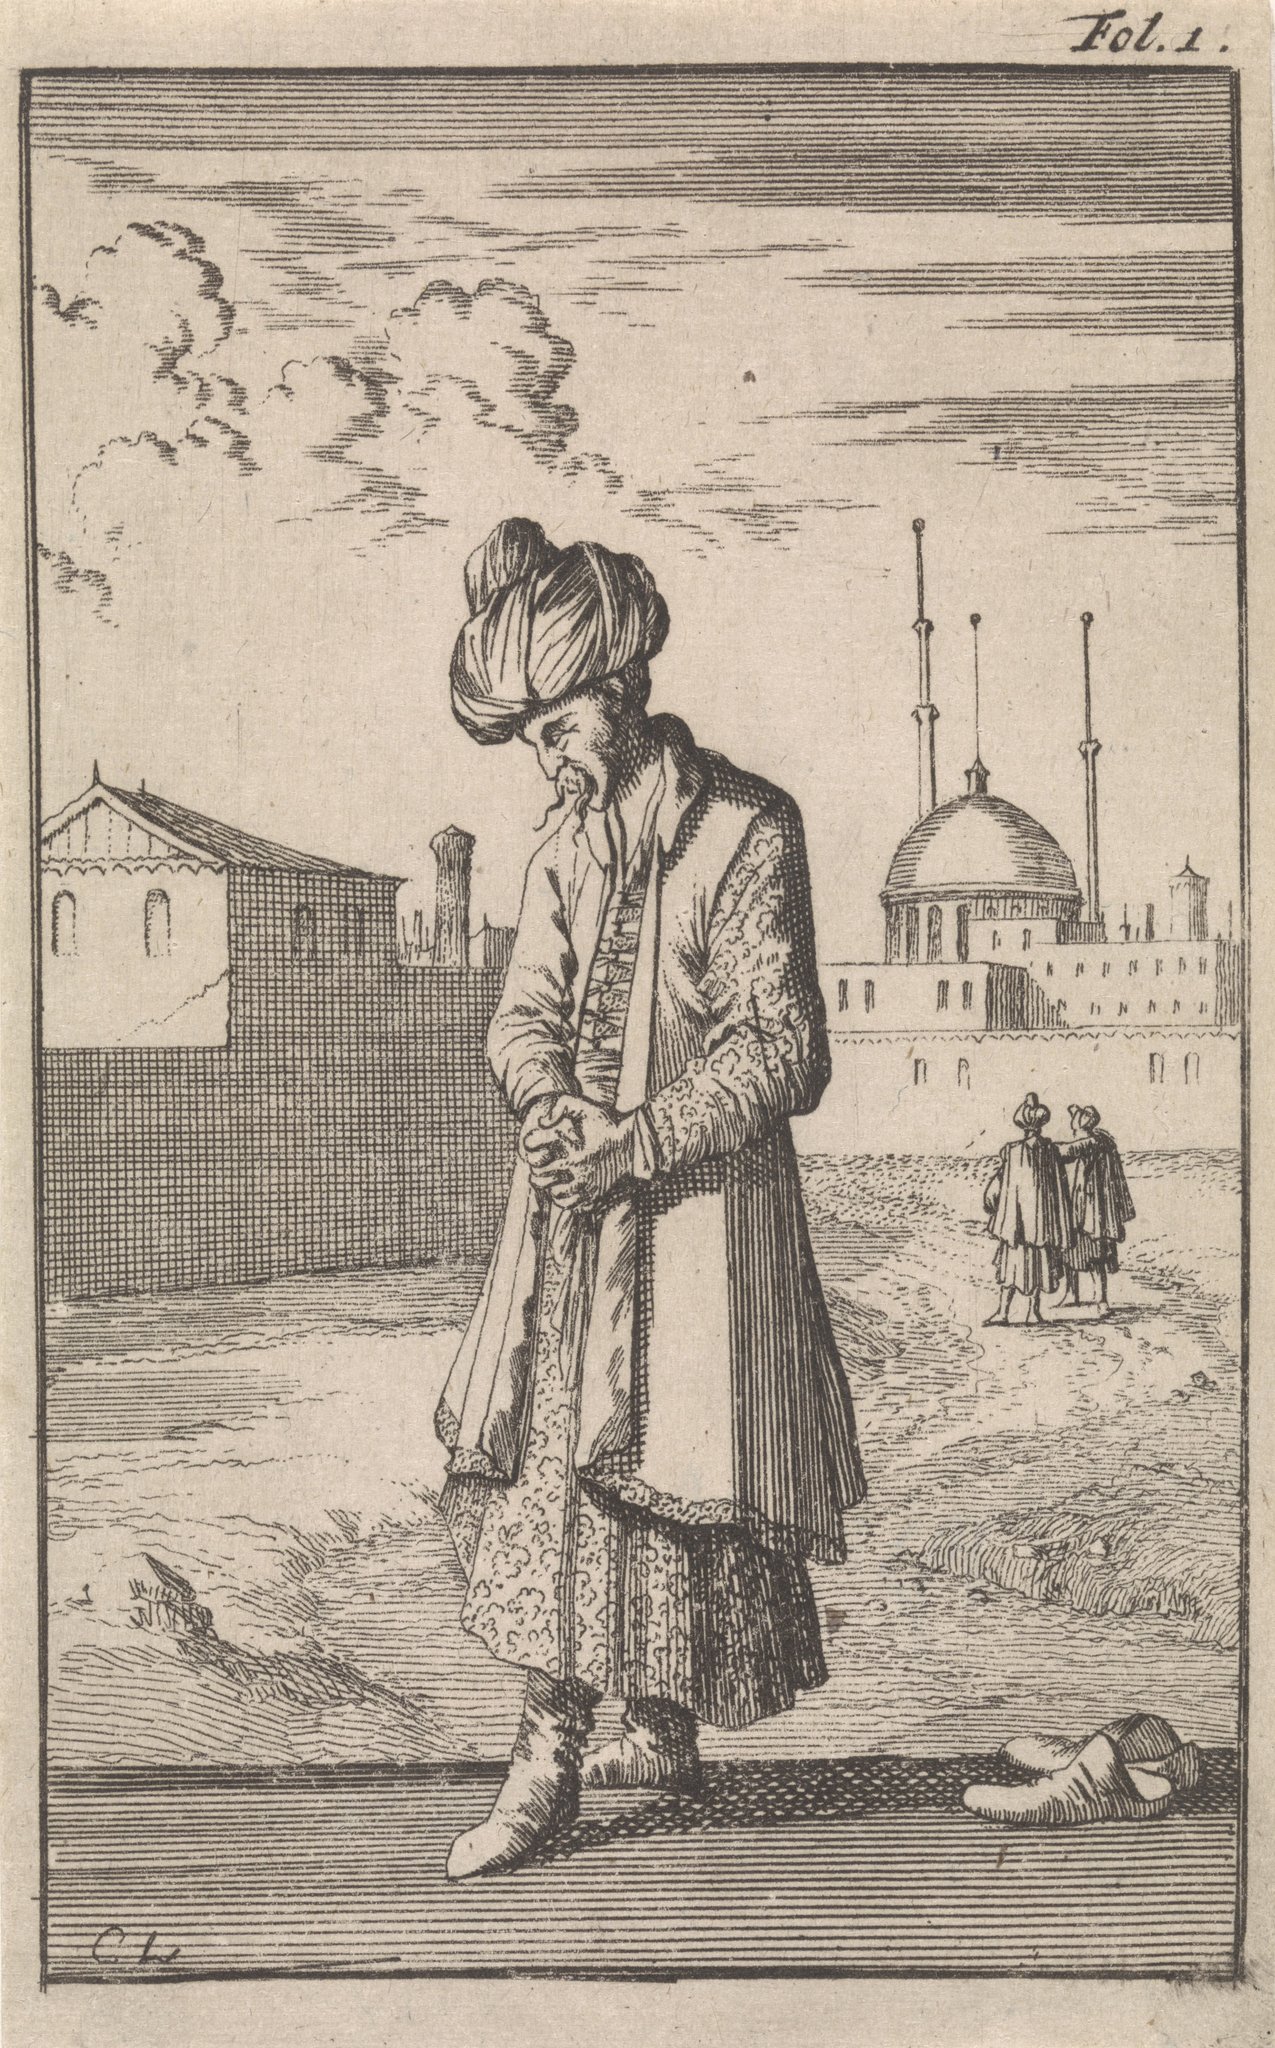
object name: book illustration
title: Staande Turk in gebed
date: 1696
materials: paper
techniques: etching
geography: amsterdam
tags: asiatic races and peoples: turks, one person praying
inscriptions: collector's mark: Lugt 2228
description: Illustratie uit: Ryer, André du. Mahomets Alkoran. [vertaald uit het Frans door] Jan Hendrik Glazemaker. Amsterdam: Timotheus ten Hoorn, 1696.